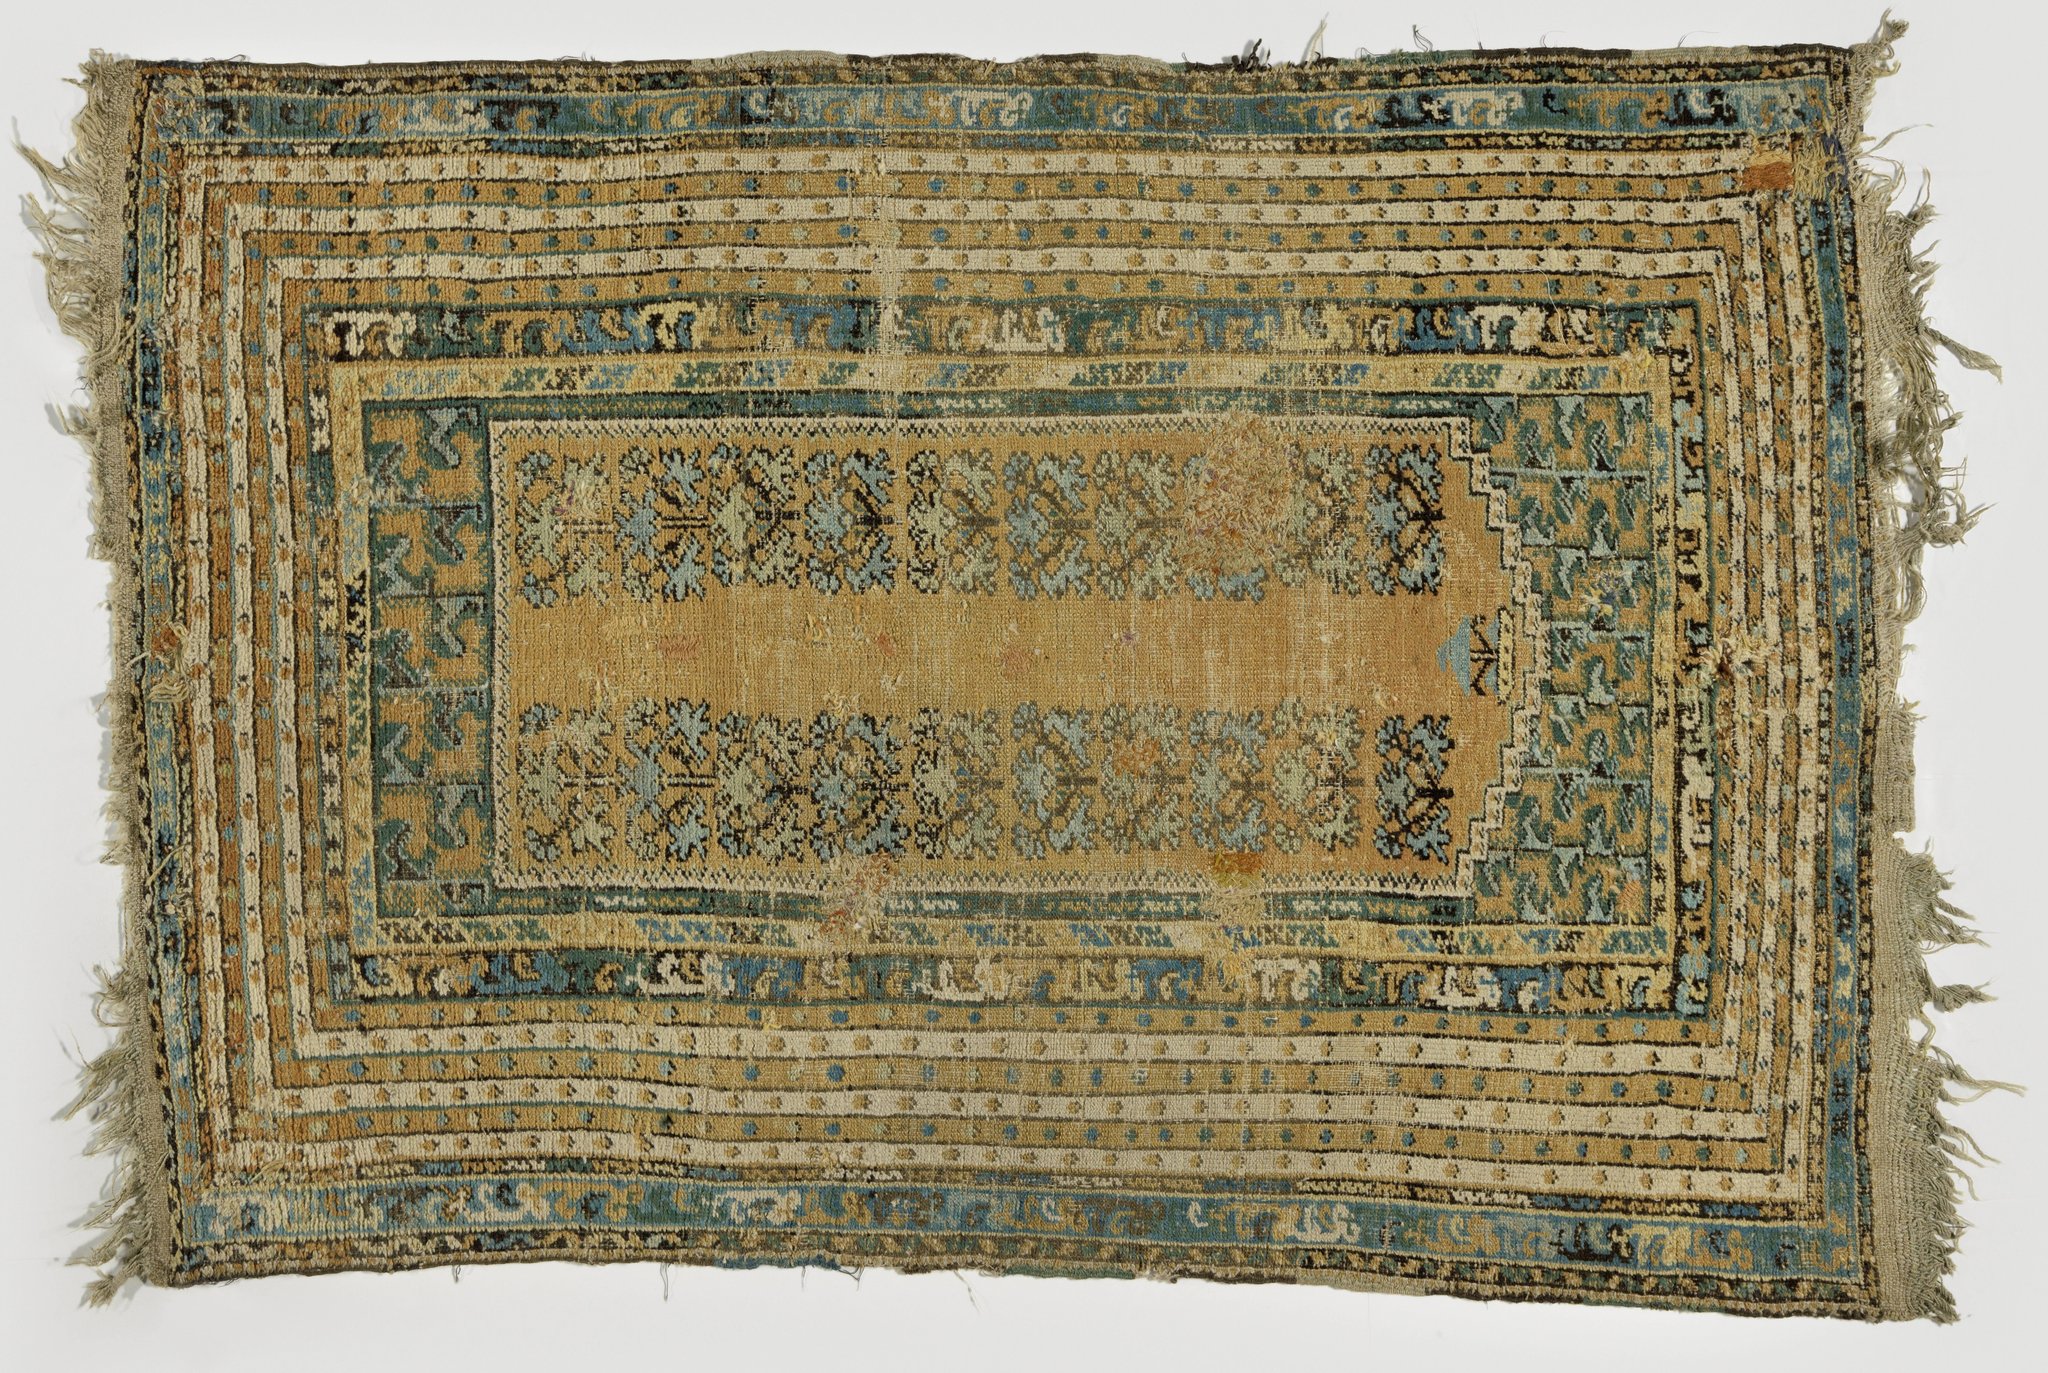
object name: prayer rug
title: Oosters tapijt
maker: Anonymous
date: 1800-1815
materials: wool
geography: kula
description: Oosters tapijt, bidkleed, van geknoopte wol, versierd met een okergele mihrab, met een lage witgetande trapgevel. In de top hangt een lamp. Twee zuilen opgetrokken uit bloemenslingers. Rondom drie randen en vier zomen.